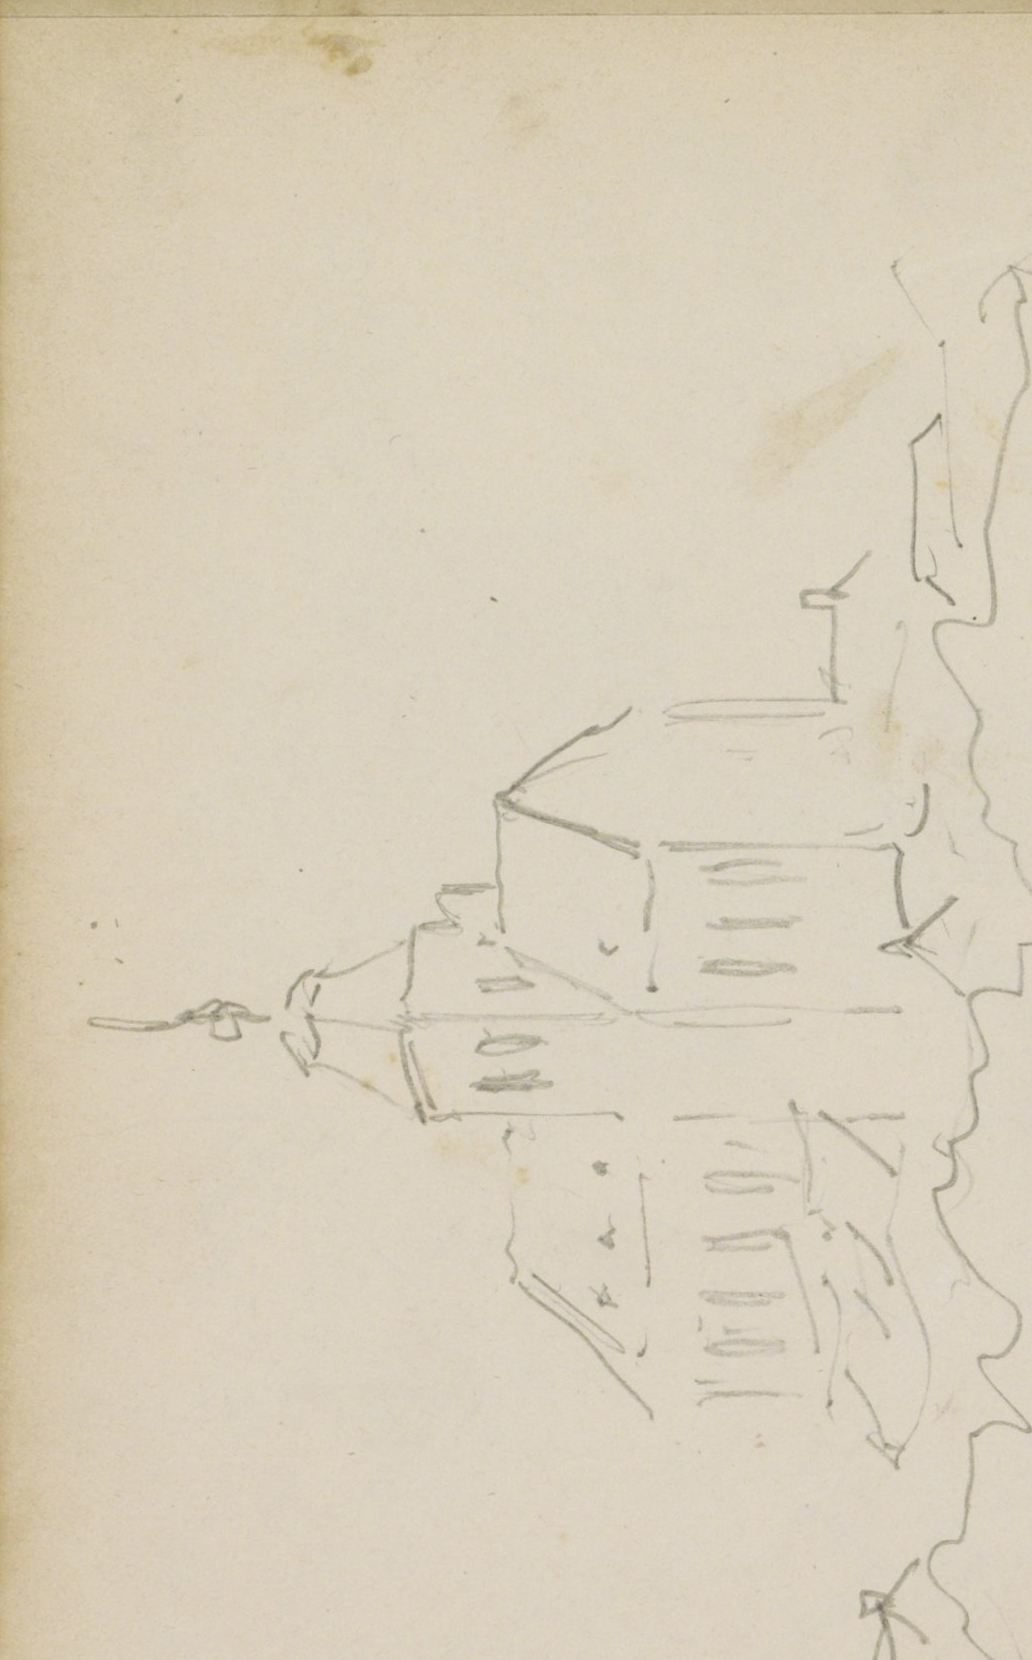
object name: sketchbook leaf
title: Kerk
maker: johannes tavenraat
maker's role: draughtsman, painter, print maker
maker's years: 1809-1881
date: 1839-1872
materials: paper, pencil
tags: church (exterior)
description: Blad 23 verso uit een schetsboek met 73 bladen.